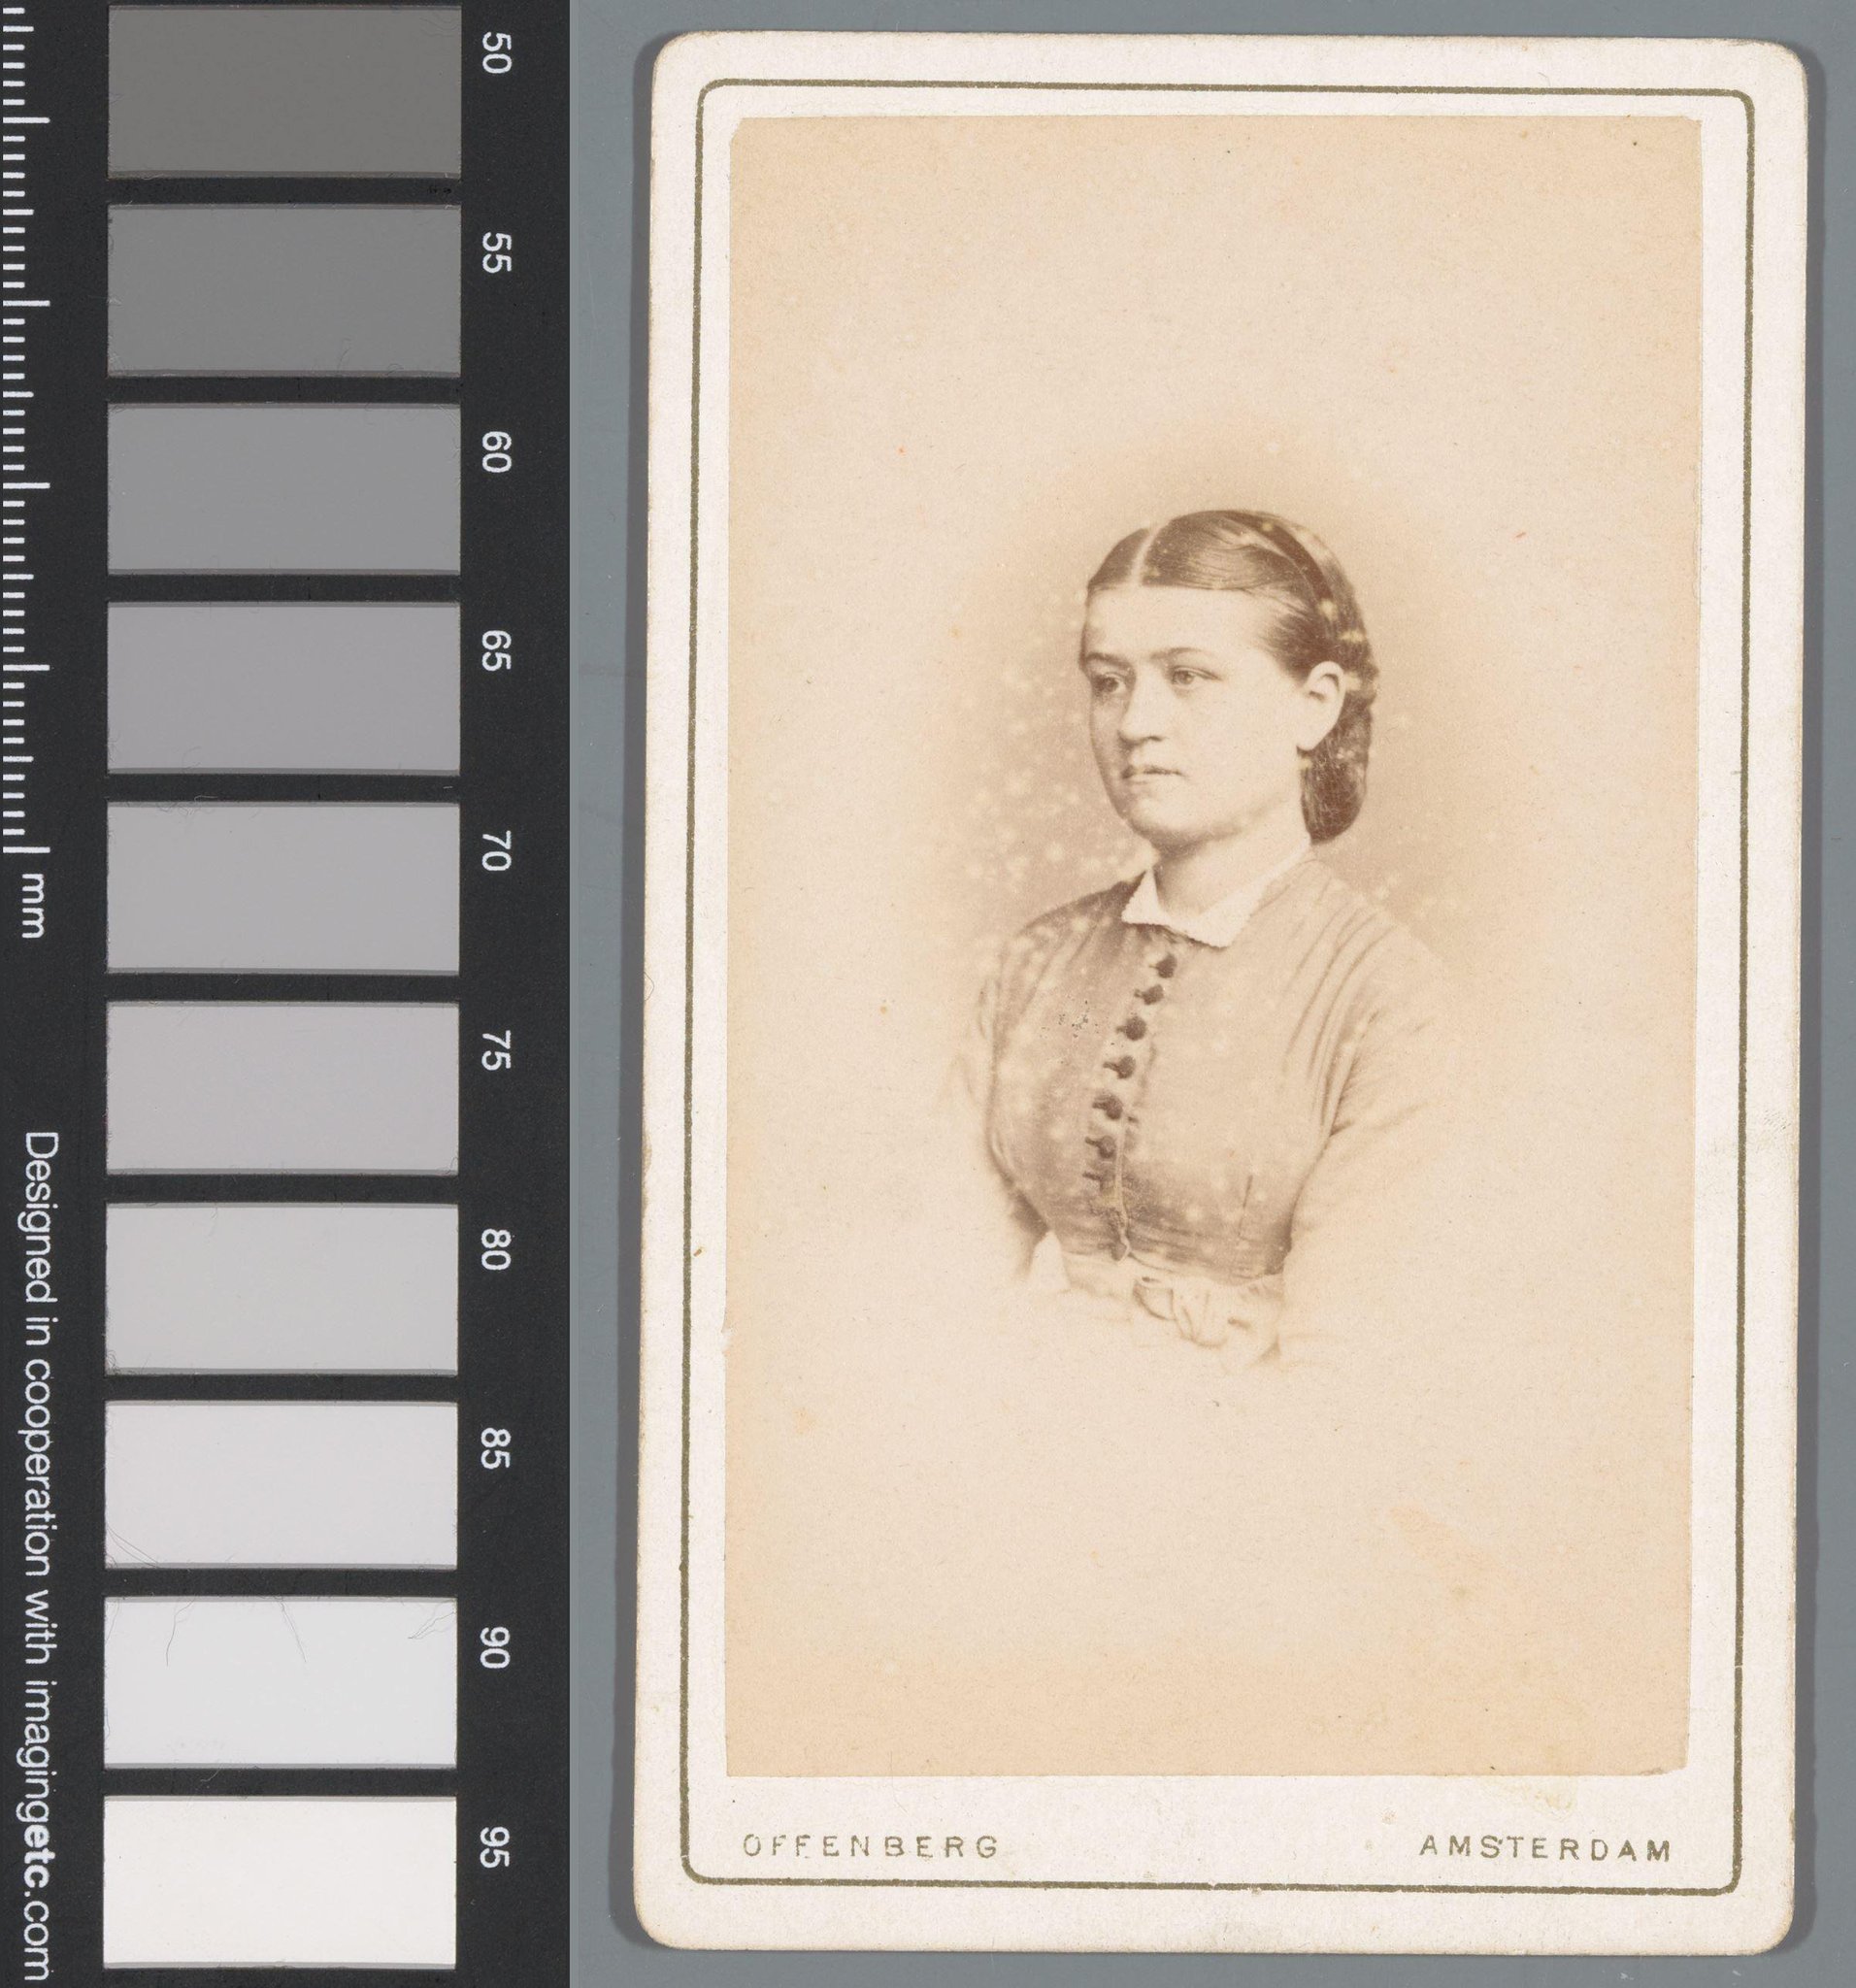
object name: photograph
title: Portret van een onbekende vrouw, aangeduid als Nelletje Zwemmer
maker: johannes wilhelmus franciscus offenberg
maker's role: fotograaf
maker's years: 1839-1919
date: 1867-1888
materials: cardboard, paper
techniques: albumen print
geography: amsterdam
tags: historical persons - bb - woman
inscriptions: inscription: ‘Nelletje Zwemmer’, inscription: ‘OFFENBERG/ PHOTOGRAPHE/ DE S.M. LA REINE DES PAYS-BAS/ Damstraat/ AMSTERDAM’